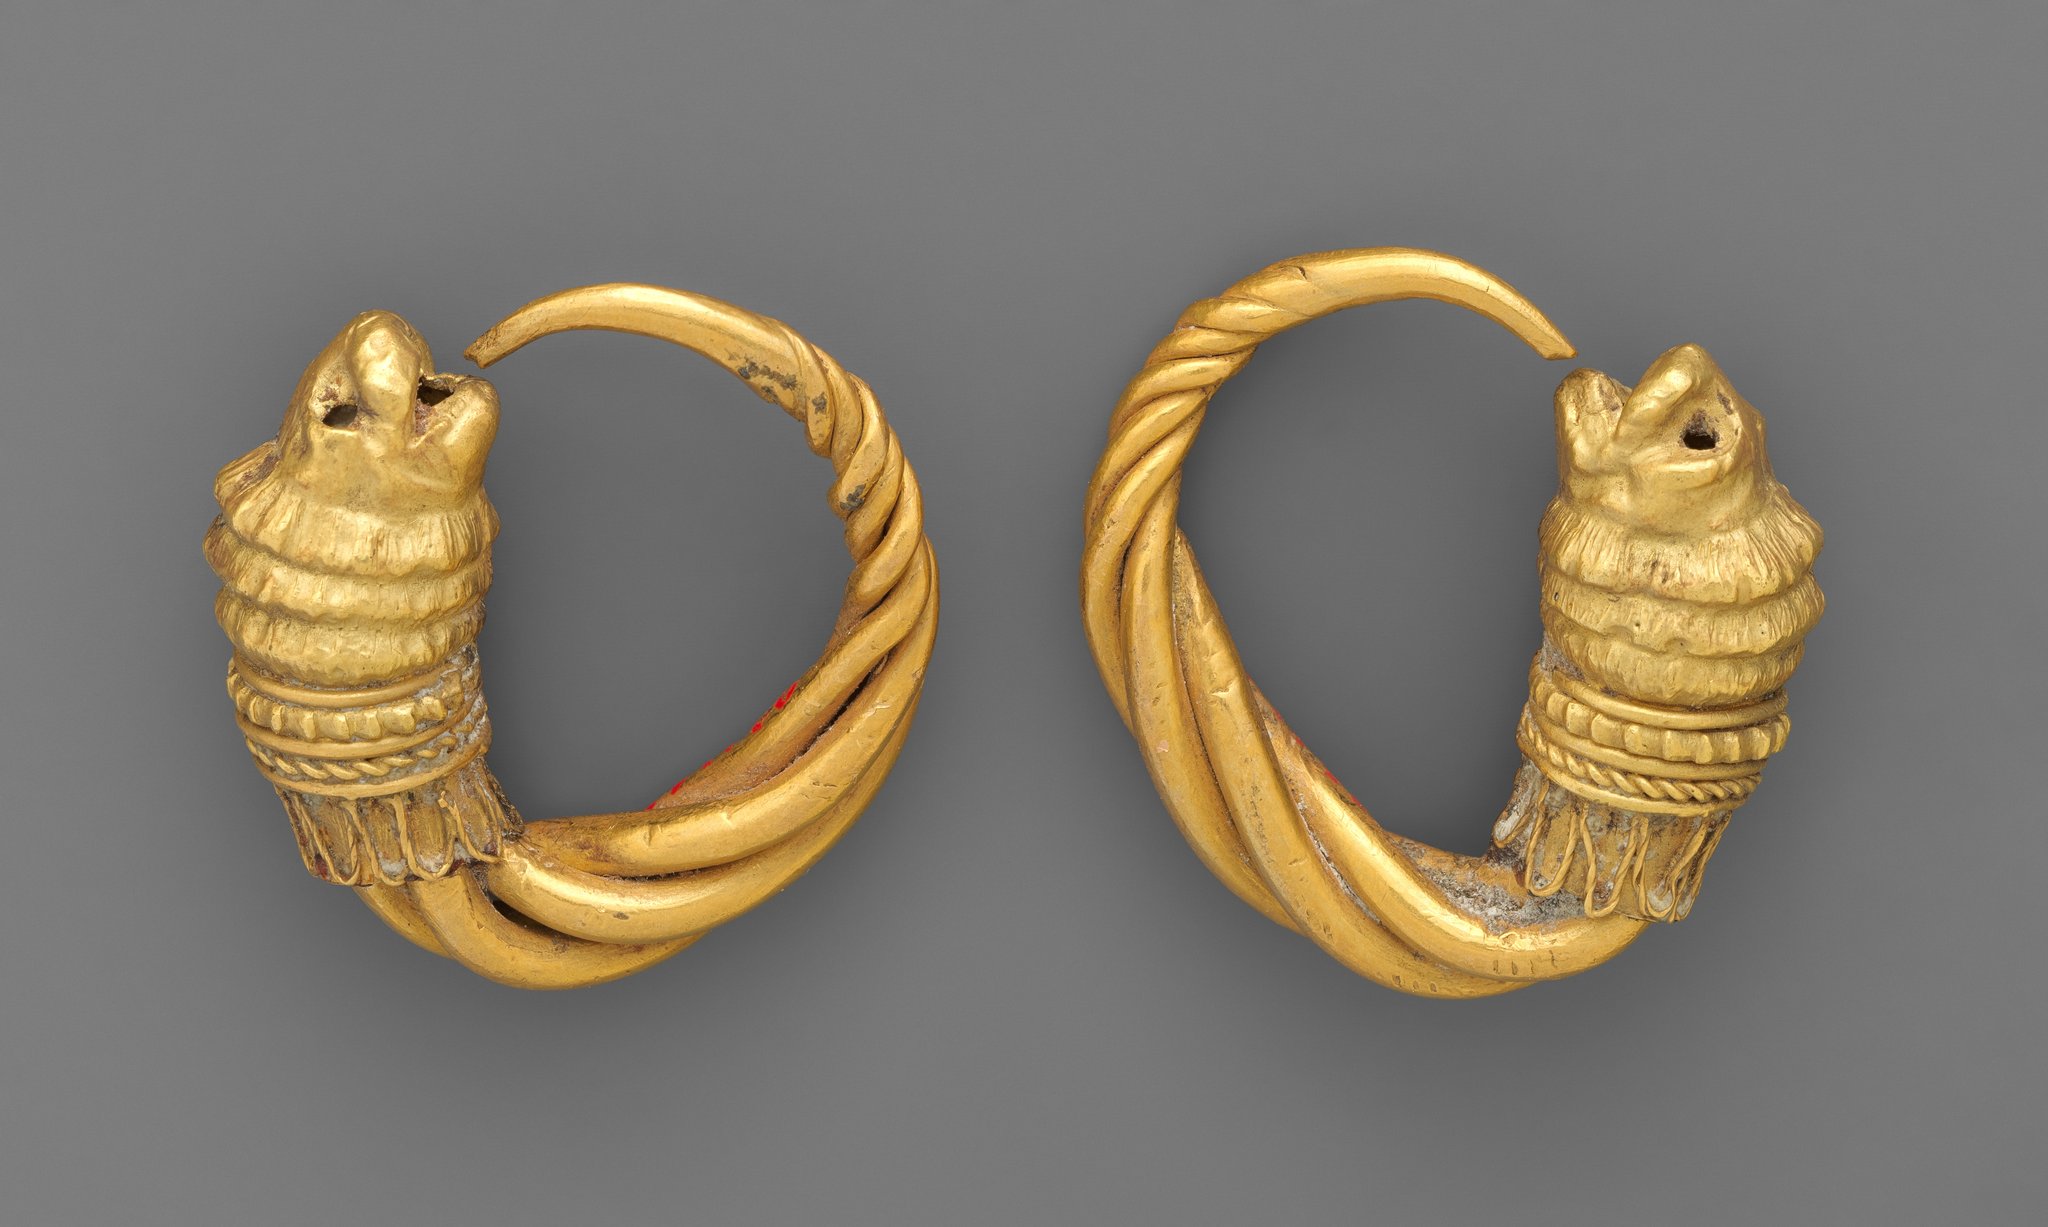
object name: earring with head of lion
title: Earring with head of lions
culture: greek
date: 500-301 BCE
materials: gold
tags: lions